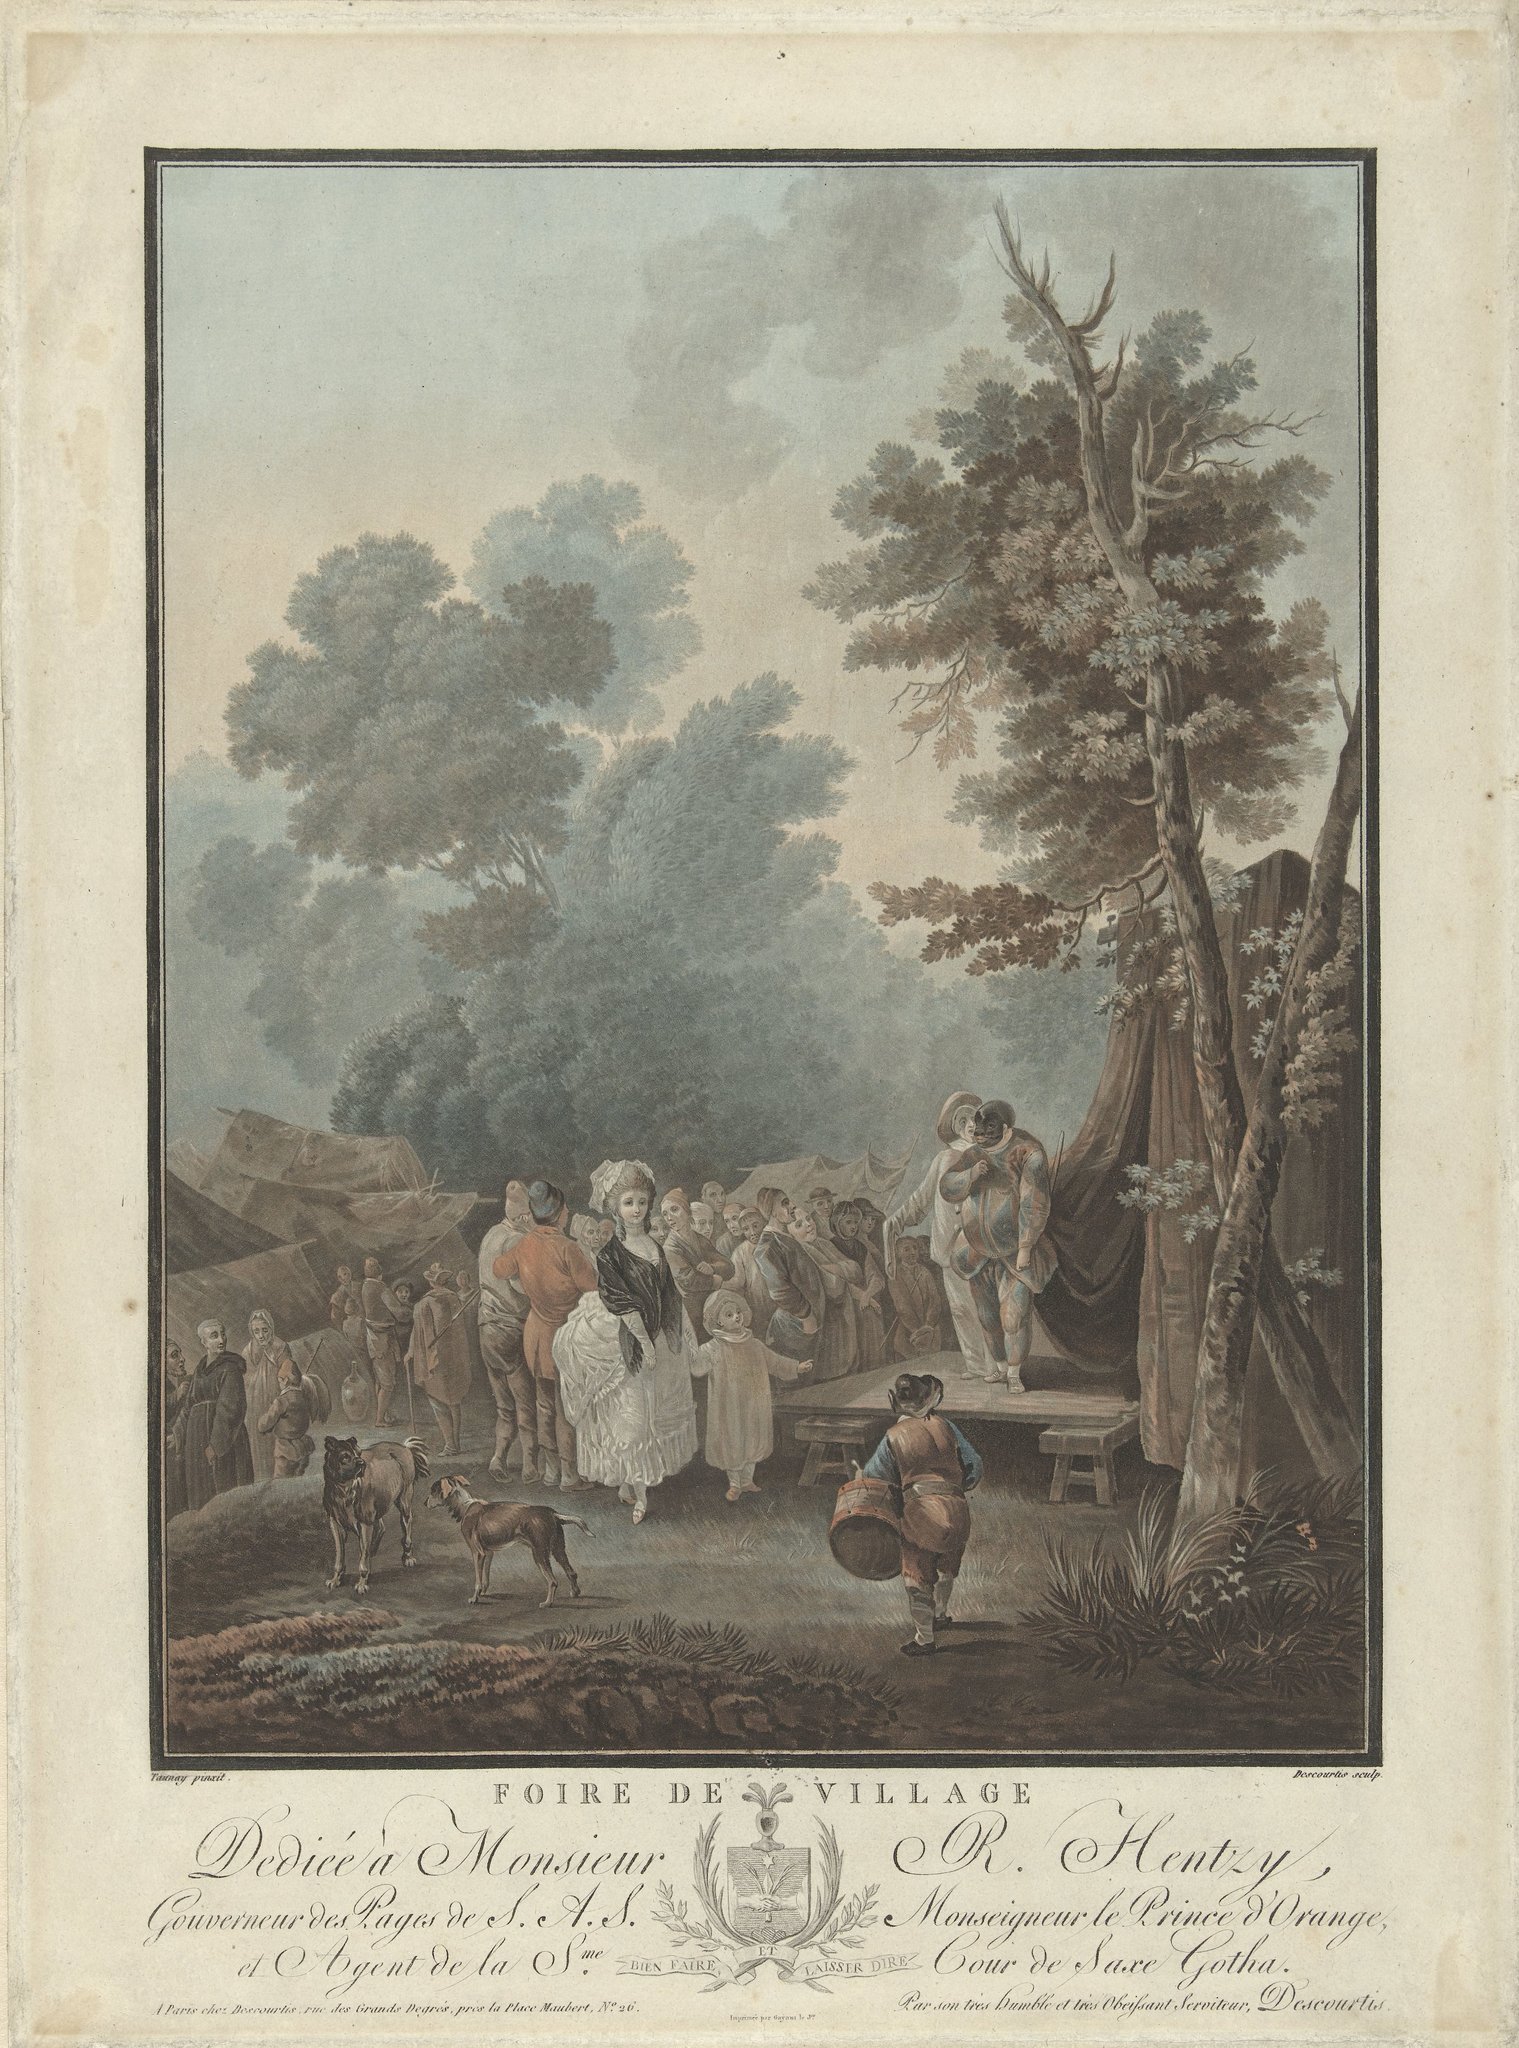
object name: print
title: Foire de Village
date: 1788-1789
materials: paper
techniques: color aquatint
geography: paris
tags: performance in the open air (pleasure fair)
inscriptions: collector's mark: Lugt 2760, collector's mark: Lugt 2228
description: Een dorpsfeest met een harlekijn en een pierrot op een podium, op de voorgrond een jongen met een trommel. Onder de voorstelling tekst en een wapenschild. Onderdeel van een serie van vier genrevoorstellingen.